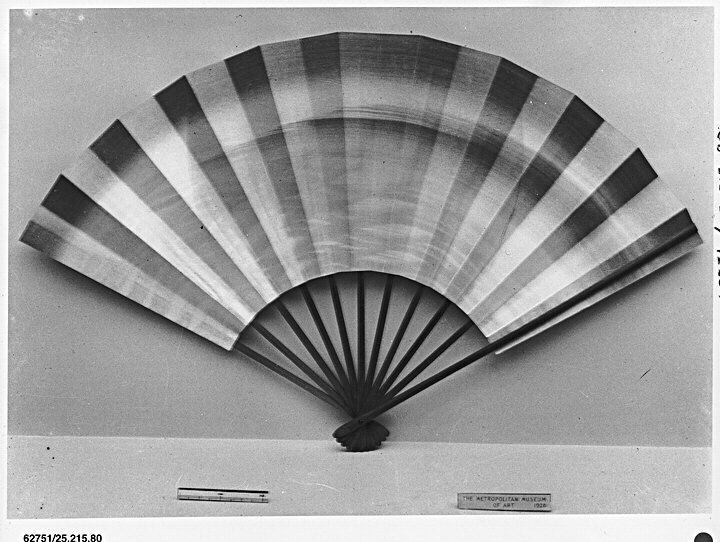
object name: folding fan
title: Fan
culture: japanese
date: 1901-2000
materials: metal, paint, paper